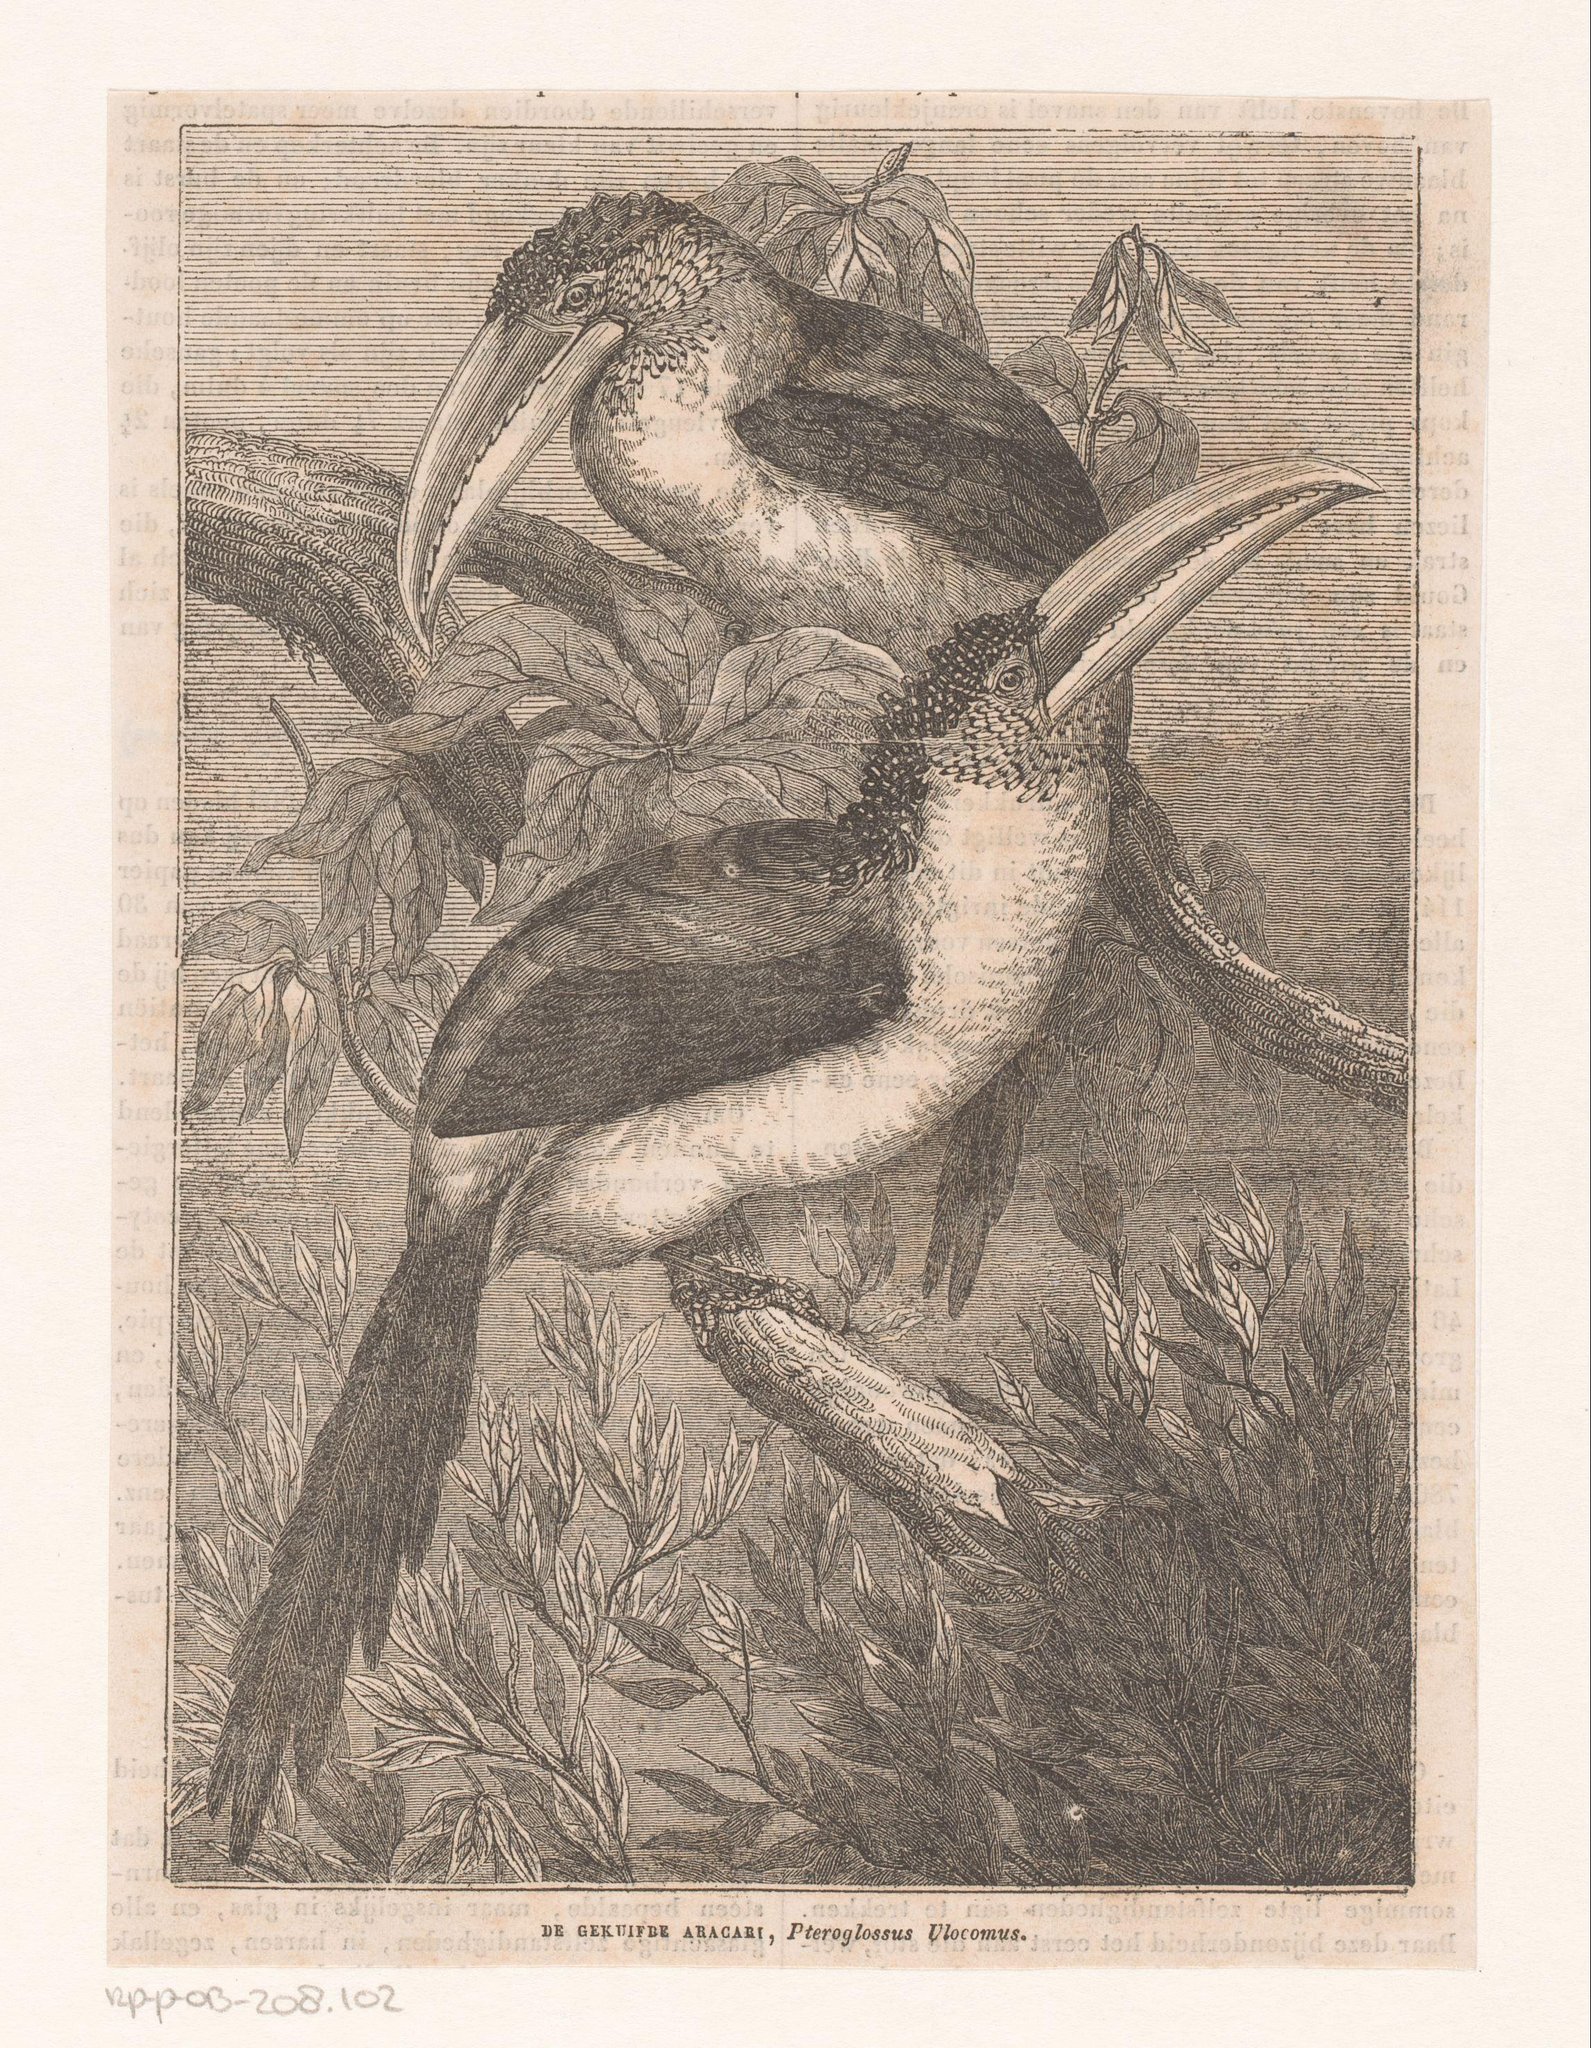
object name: book illustration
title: Twee gekuifde arassari op een tak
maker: Anonymous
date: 1800-1899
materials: paper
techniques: letterpress printing, engraving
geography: netherlands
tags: other birds: toucan